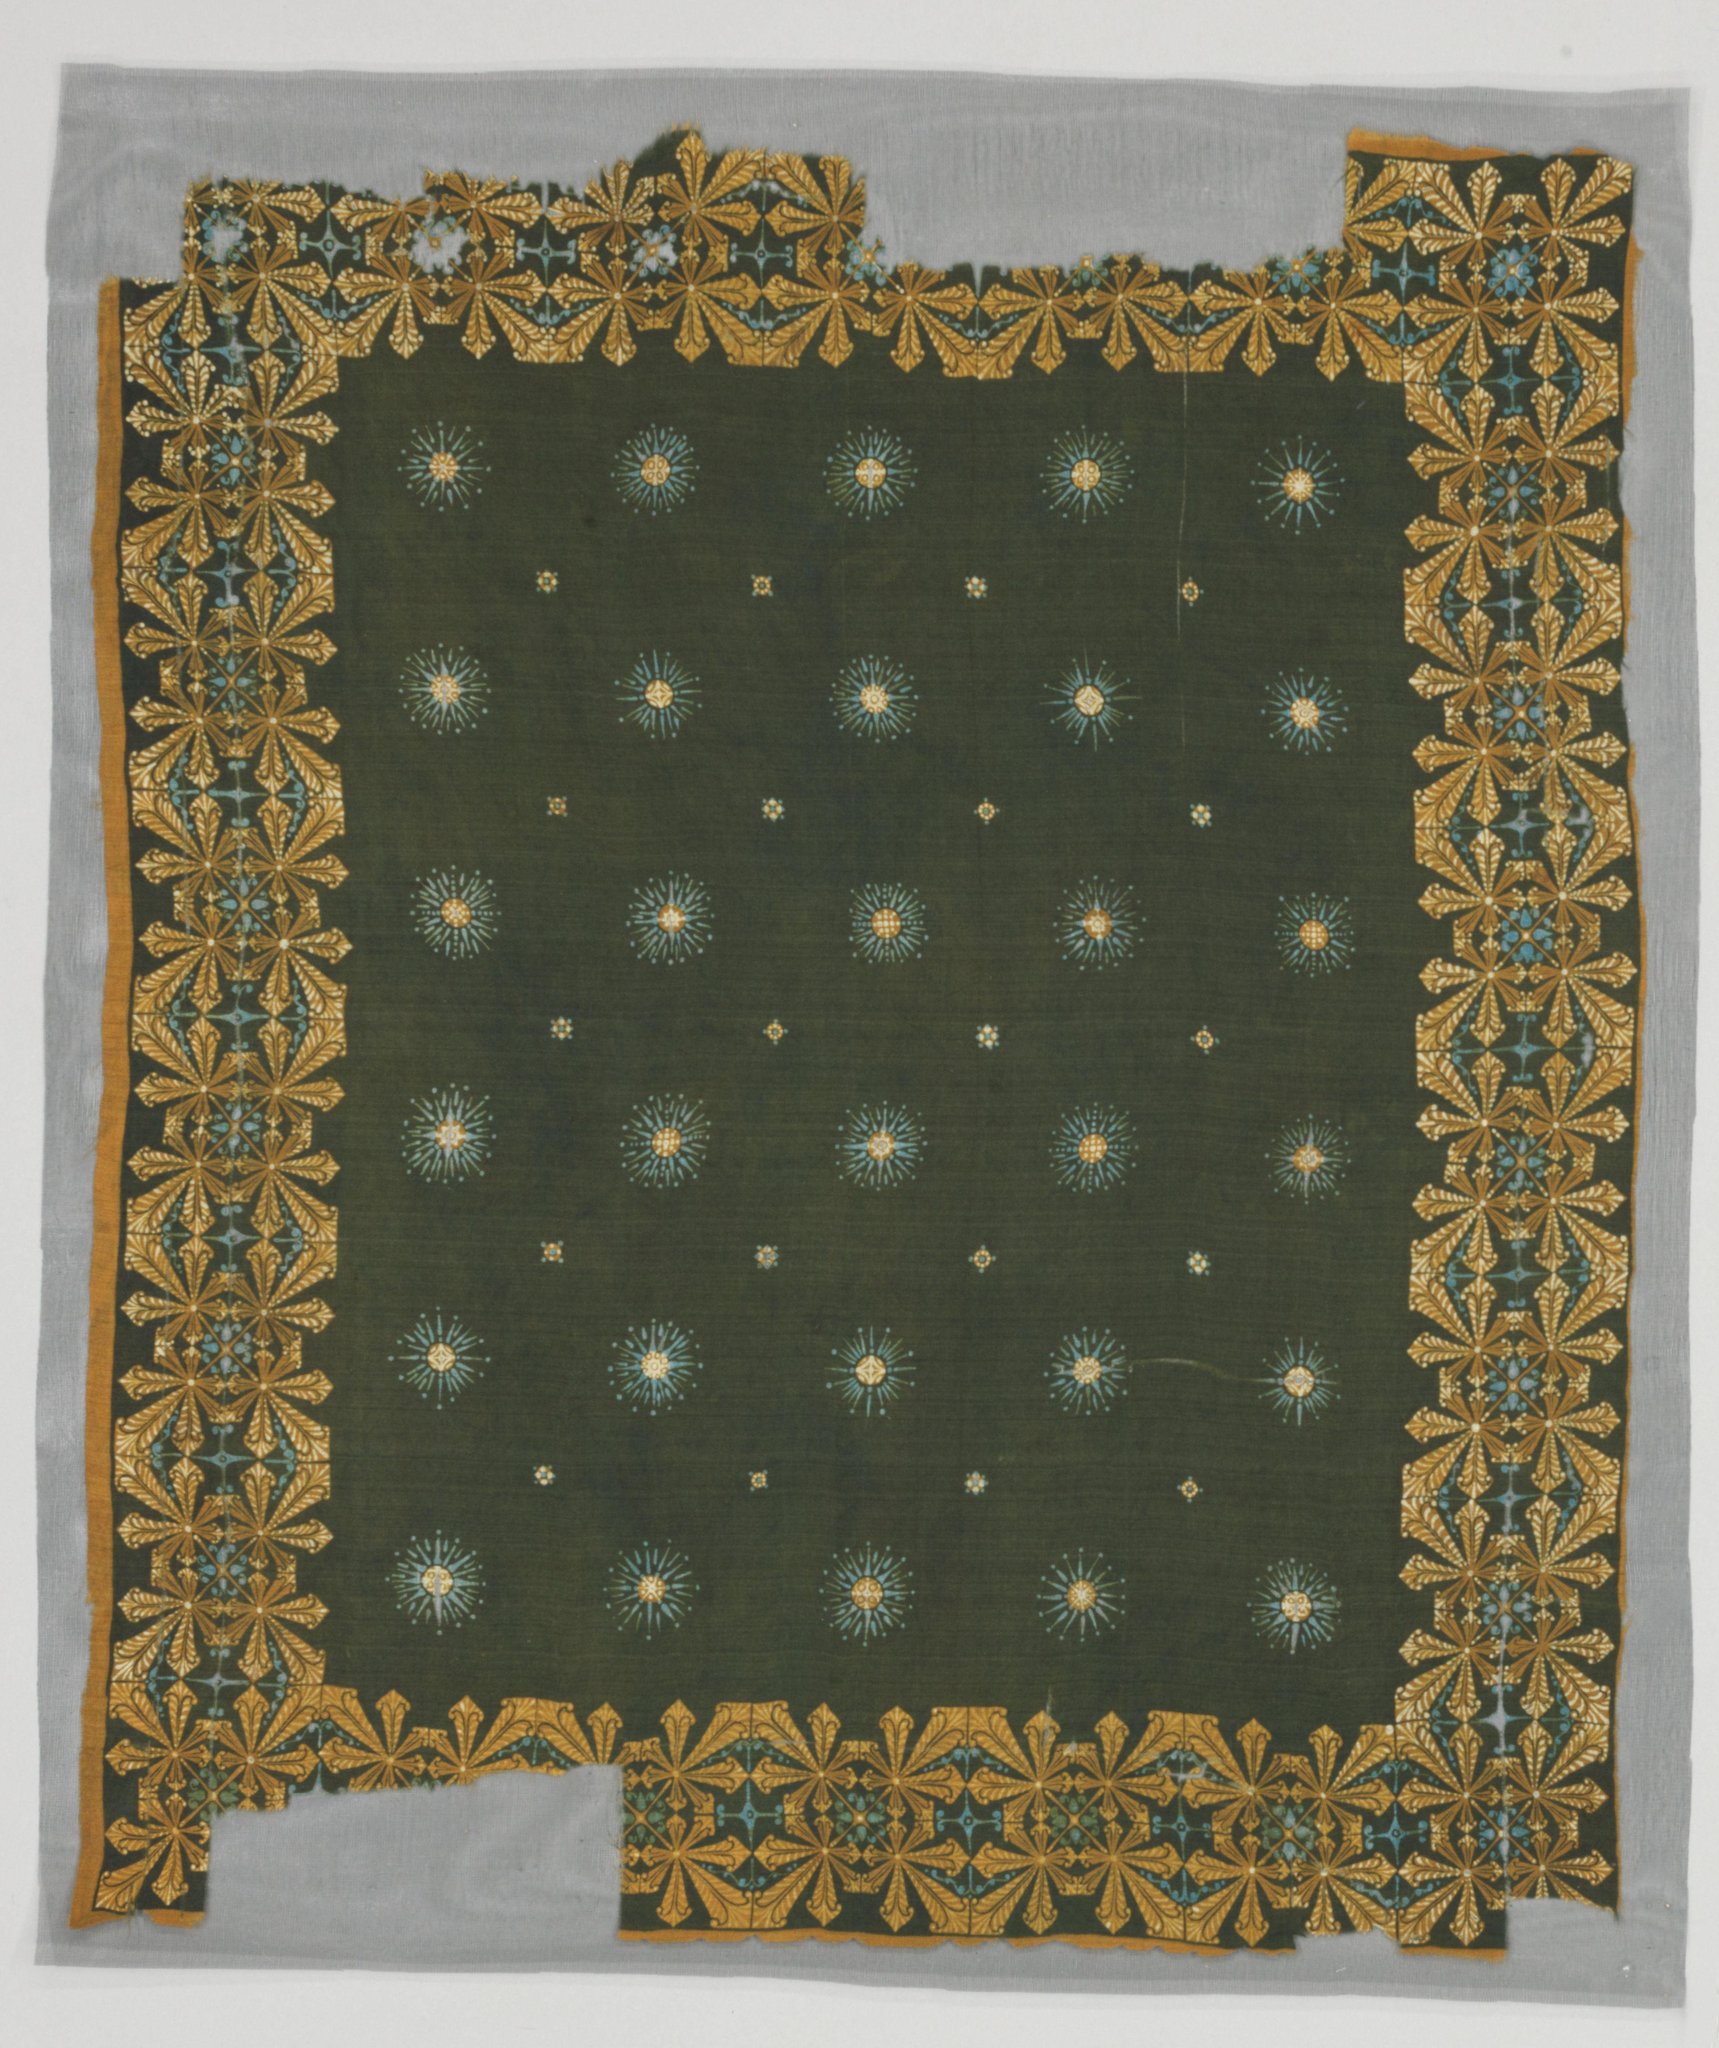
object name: panel ornament area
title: Paneel van een scherm van gebatikte zijde met patroon van kastanjebladeren en -bloemen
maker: chris lebeau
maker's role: draughtsman, print maker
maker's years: 1878-1945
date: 1905-1910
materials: silk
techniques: batik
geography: haarlem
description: Paneel van een scherm van gebatikte zijde met randpatroon van kastanjebladeren en een middenveld bezaaid met kastanjebloemen en gestileerde motieven.